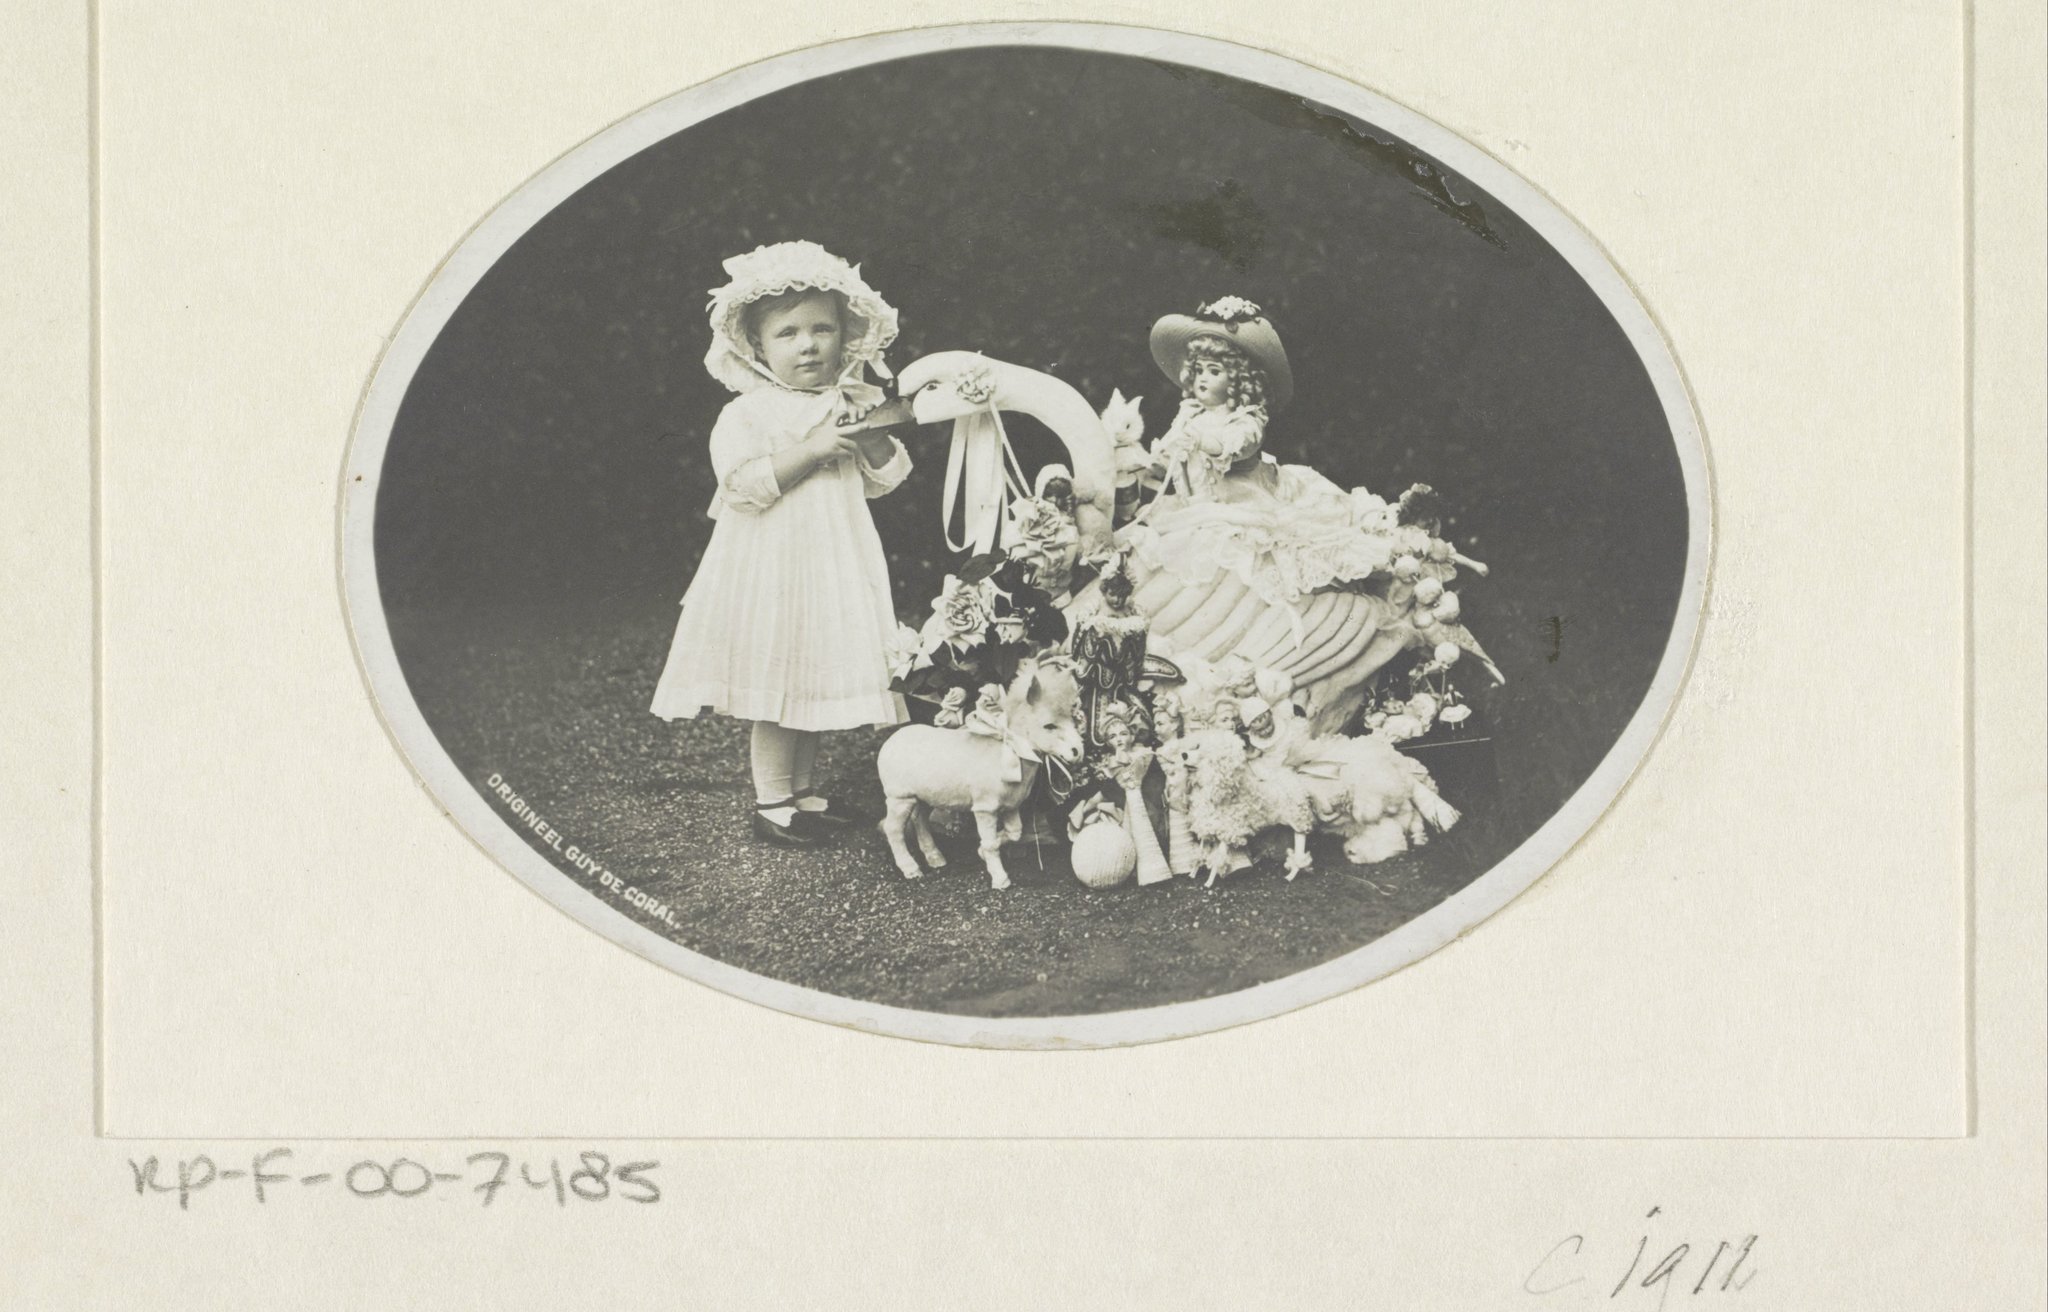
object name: photograph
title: Portret van Juliana, koningin der Nederlanden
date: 1911-1912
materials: photographic support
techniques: photography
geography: netherlands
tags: the hague, juliana of the netherlands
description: De hier vermelde titel verwijst naar de hoogst verkregen titel van de geportretteerde, niet per se naar de titel die de geportretteerde op deze voorstelling draagt.